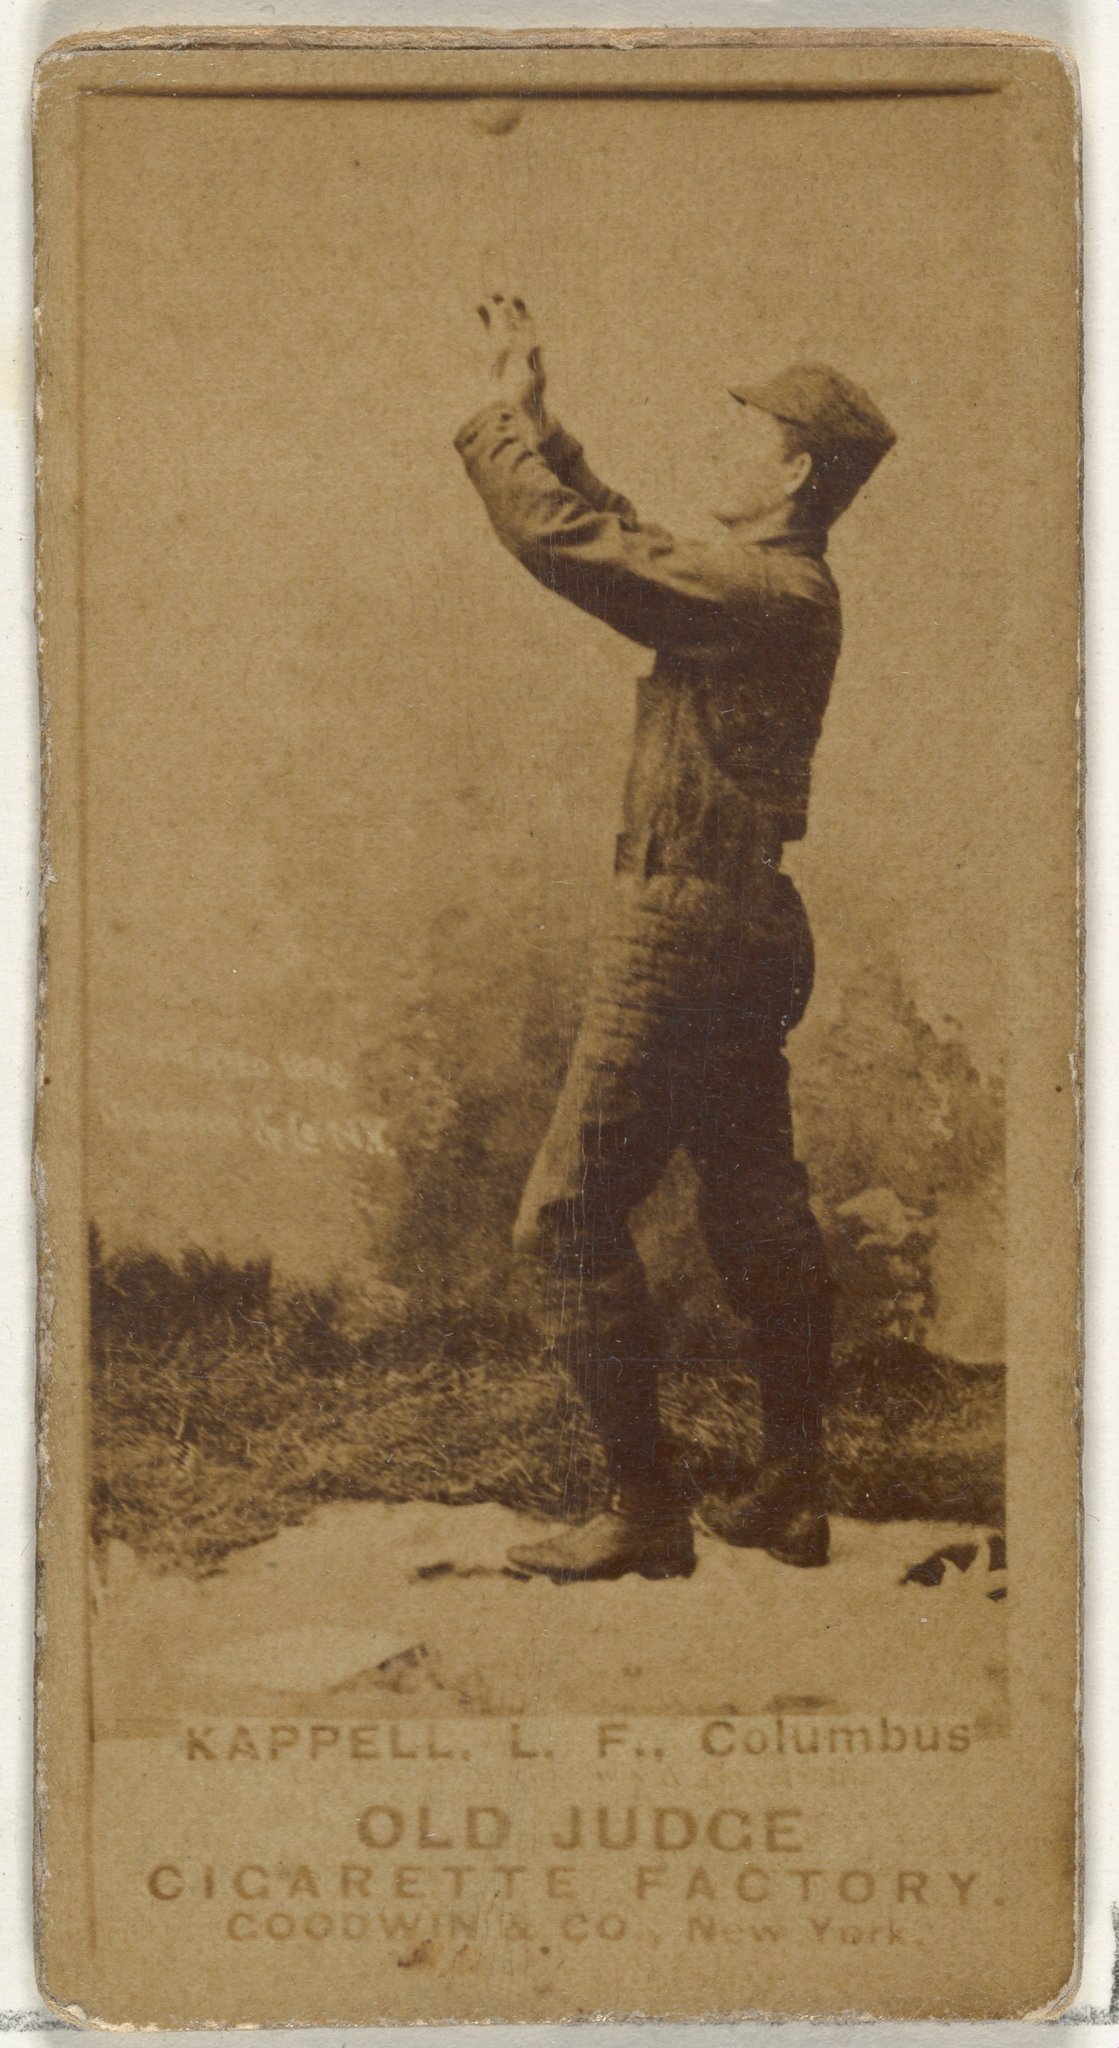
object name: baseball card, photograph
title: Henry "Heinie" Kappel, Left Field, Cleveland, from the Old Judge series (N172) for Old Judge Cigarettes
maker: goodwin & company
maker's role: publisher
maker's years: 1850-1950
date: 1888-1889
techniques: albumen silver print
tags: men,profiles,baseball,athletes